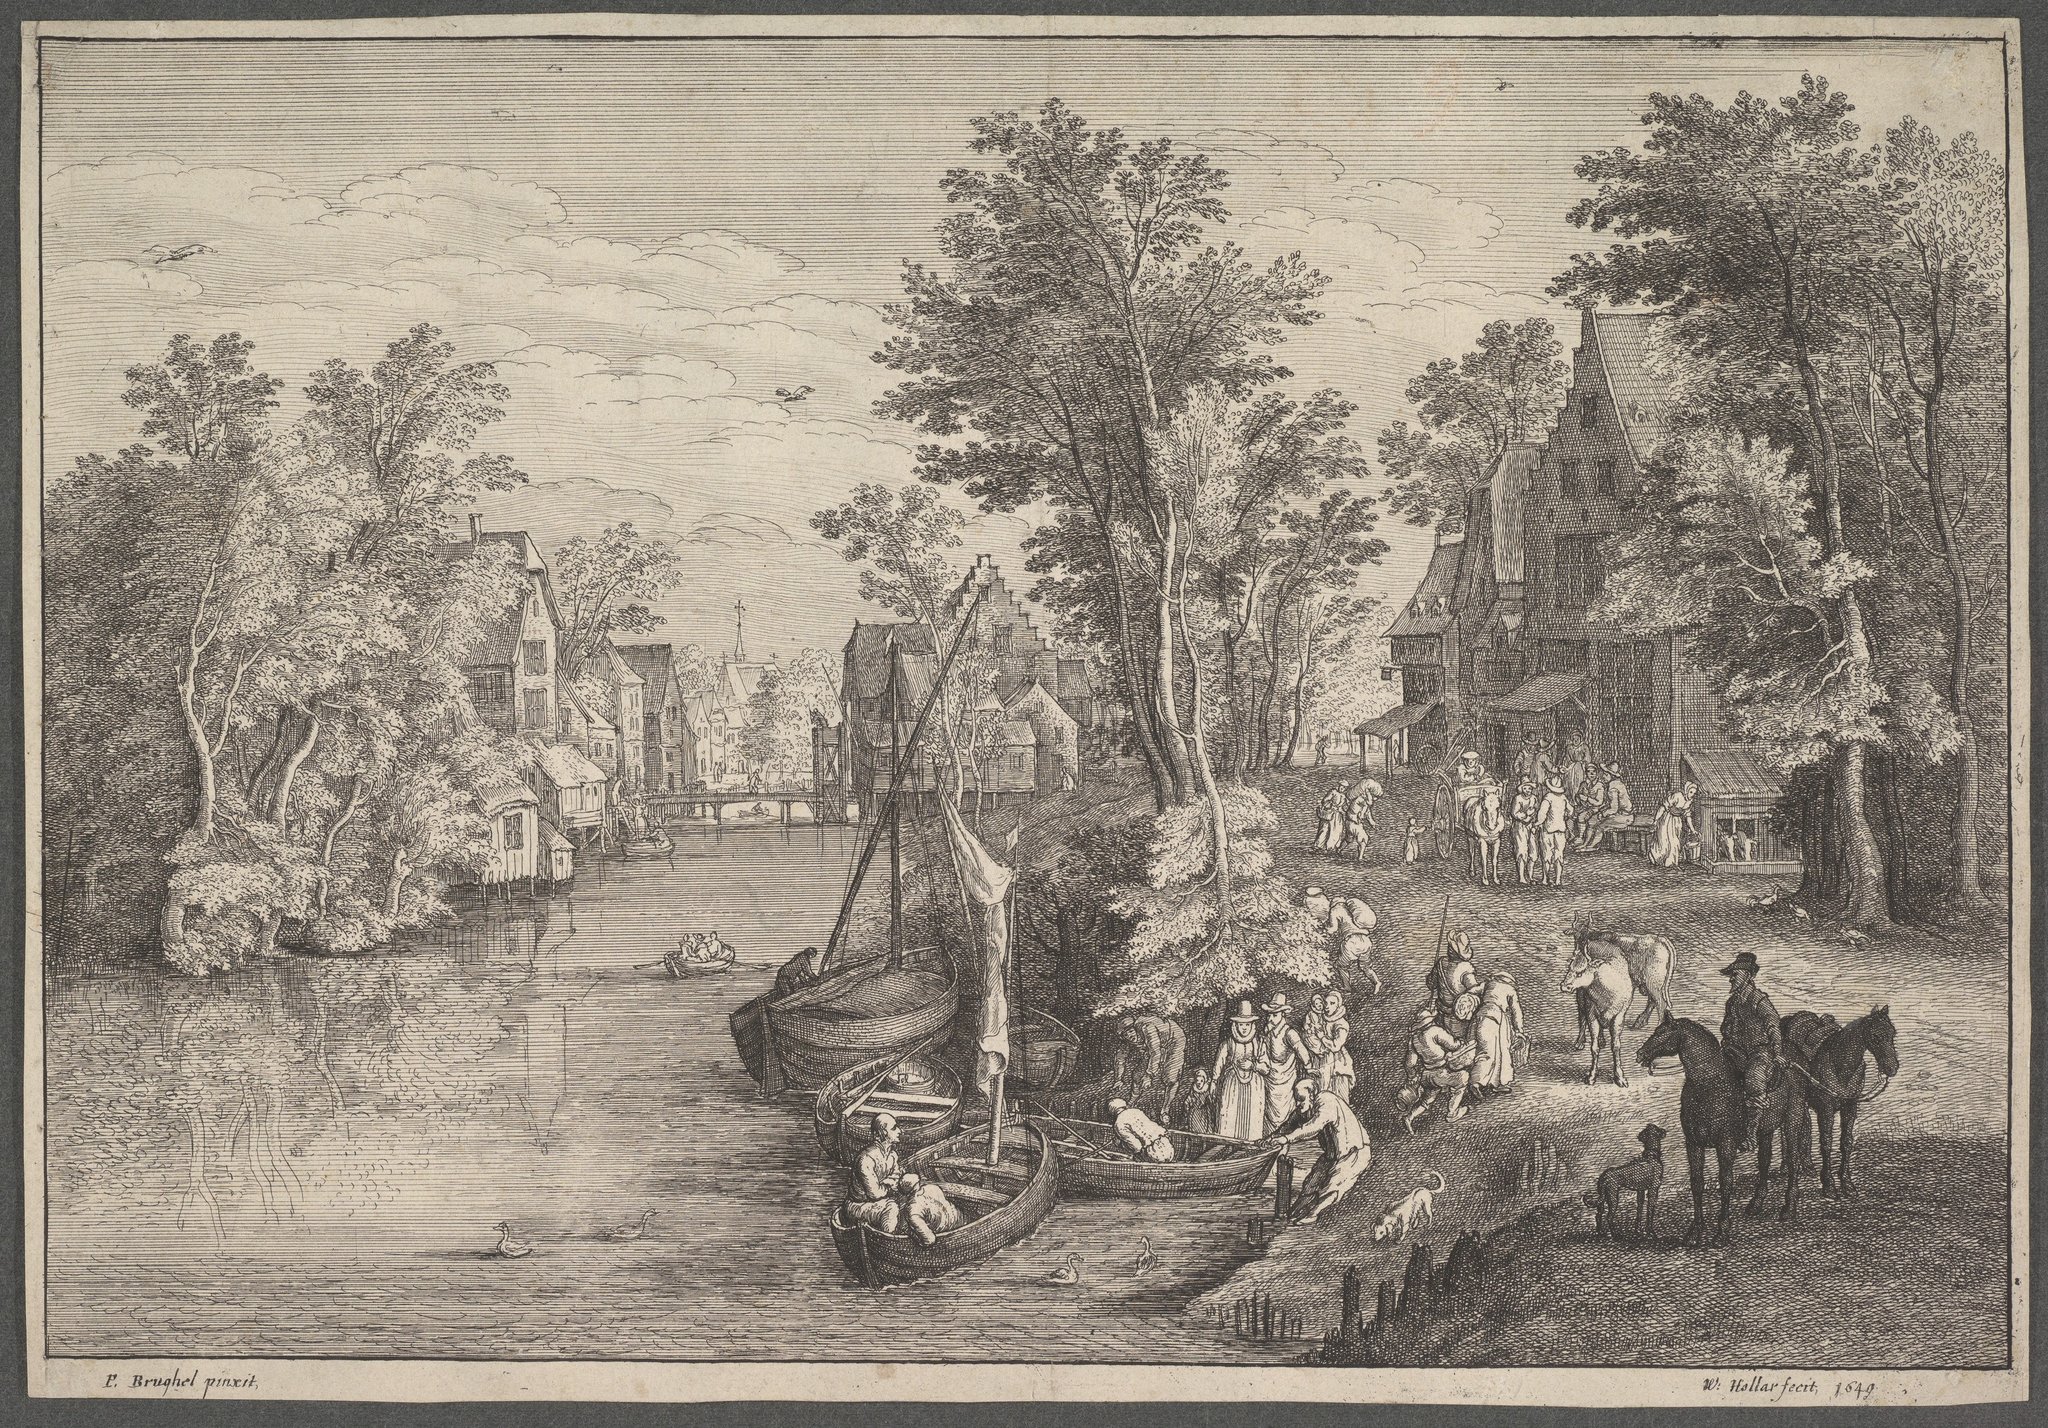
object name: print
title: The Ferry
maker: wenceslaus hollar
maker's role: artist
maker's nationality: bohemian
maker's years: 1607-1677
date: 1649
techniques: etching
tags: towns,dogs,horses,boats